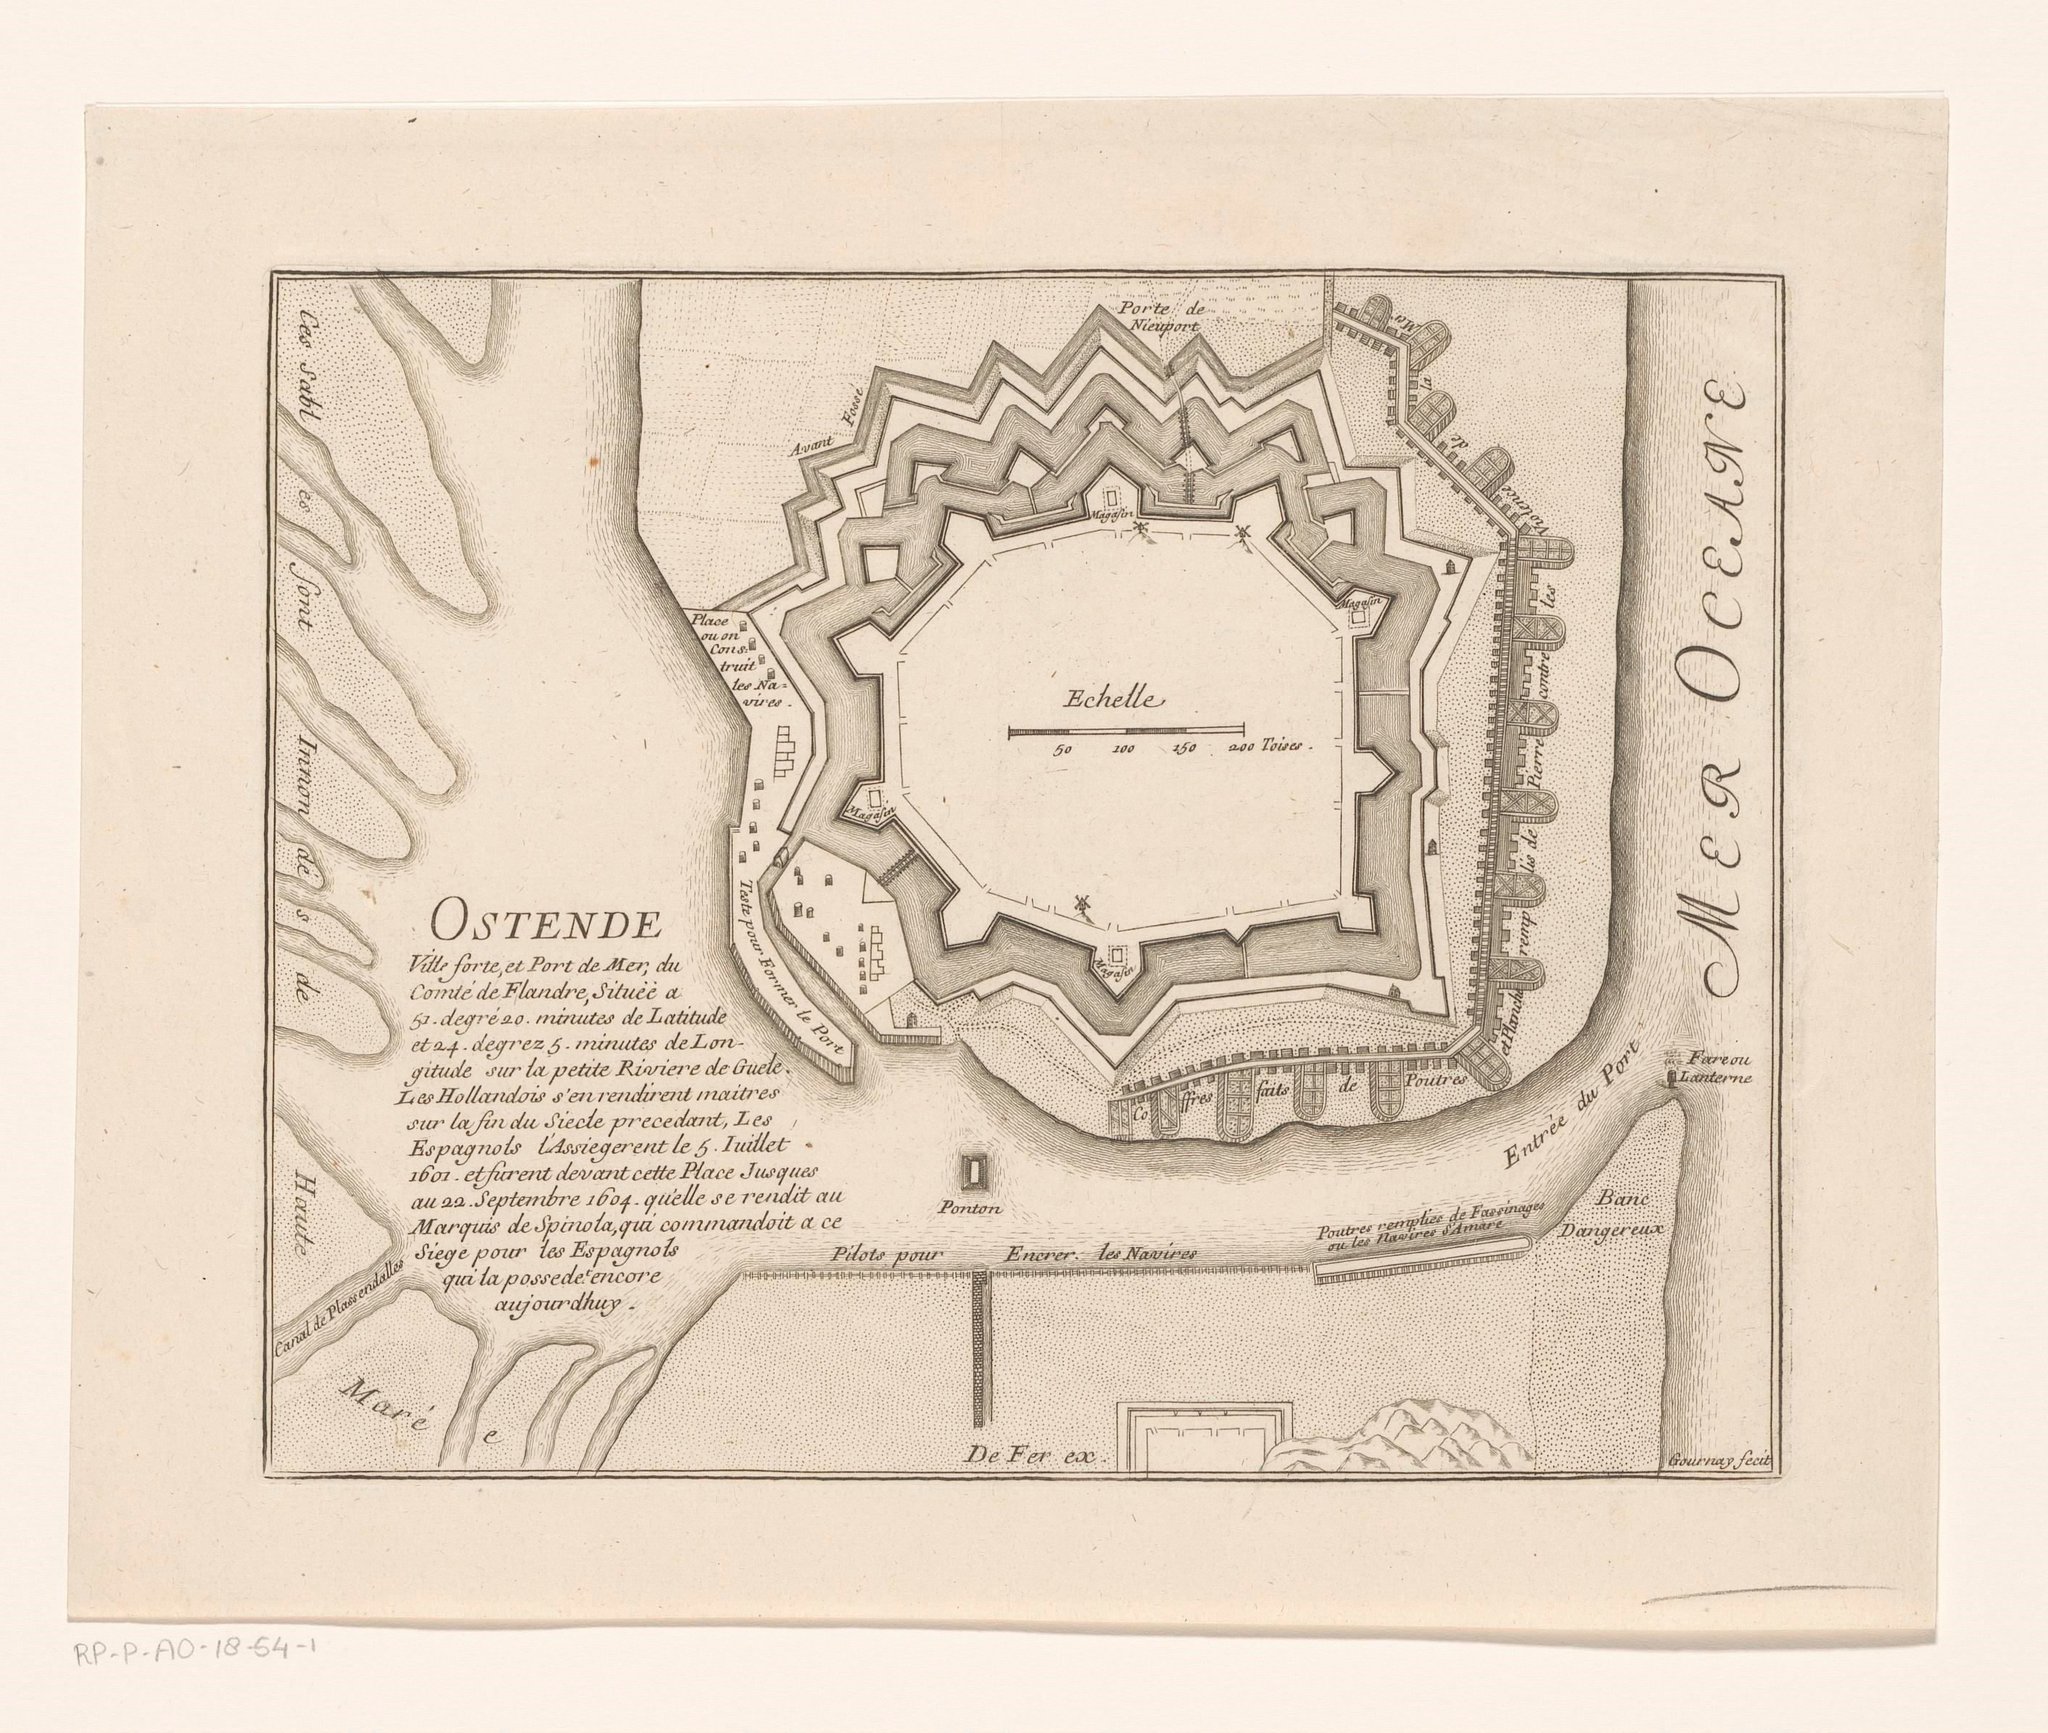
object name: area plan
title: Vestingplattegrond van Oostende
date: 1657-1720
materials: paper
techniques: engraving, etching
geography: paris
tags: fortified city, maps of cities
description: Vestingplattegrond van Oostende. Linksonder de titel en een beschrijving van Oostende. In de vesting een schaalstok: 200 Toises.